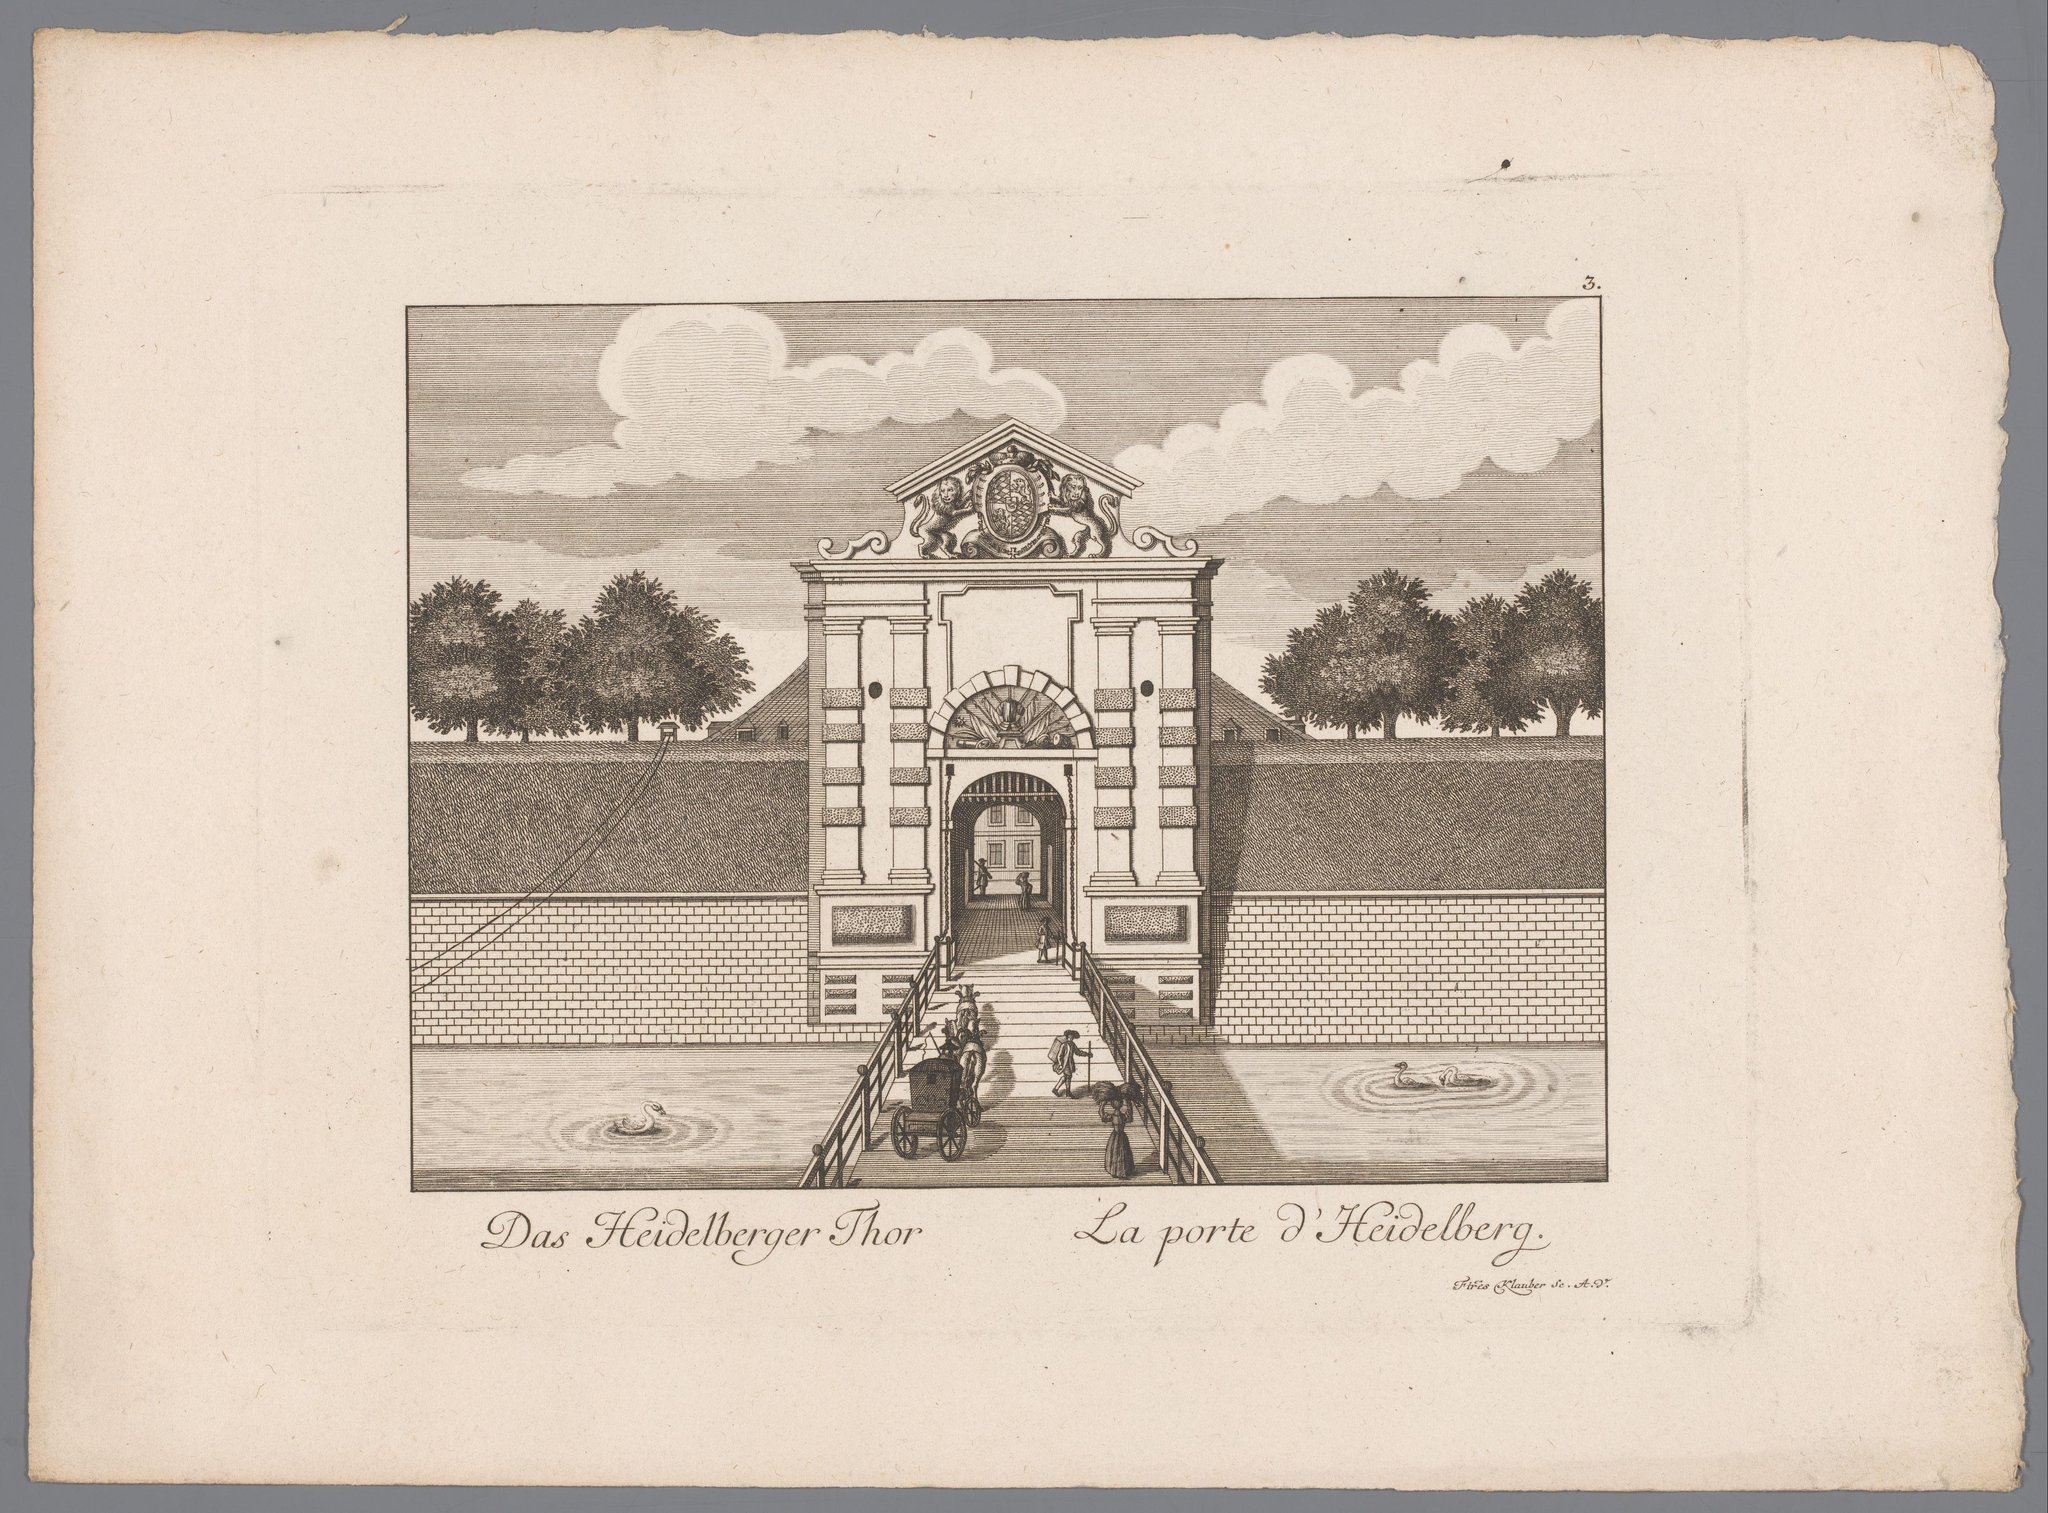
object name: print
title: Das Heiderberger Thor / La porte d'Heidelberg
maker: christian friedrich schwan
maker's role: bookseller, publisher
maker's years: 1733-1815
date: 1782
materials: paper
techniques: engraving, etching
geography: augsburg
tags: city-gate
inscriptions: collector's mark: Lugt 2228